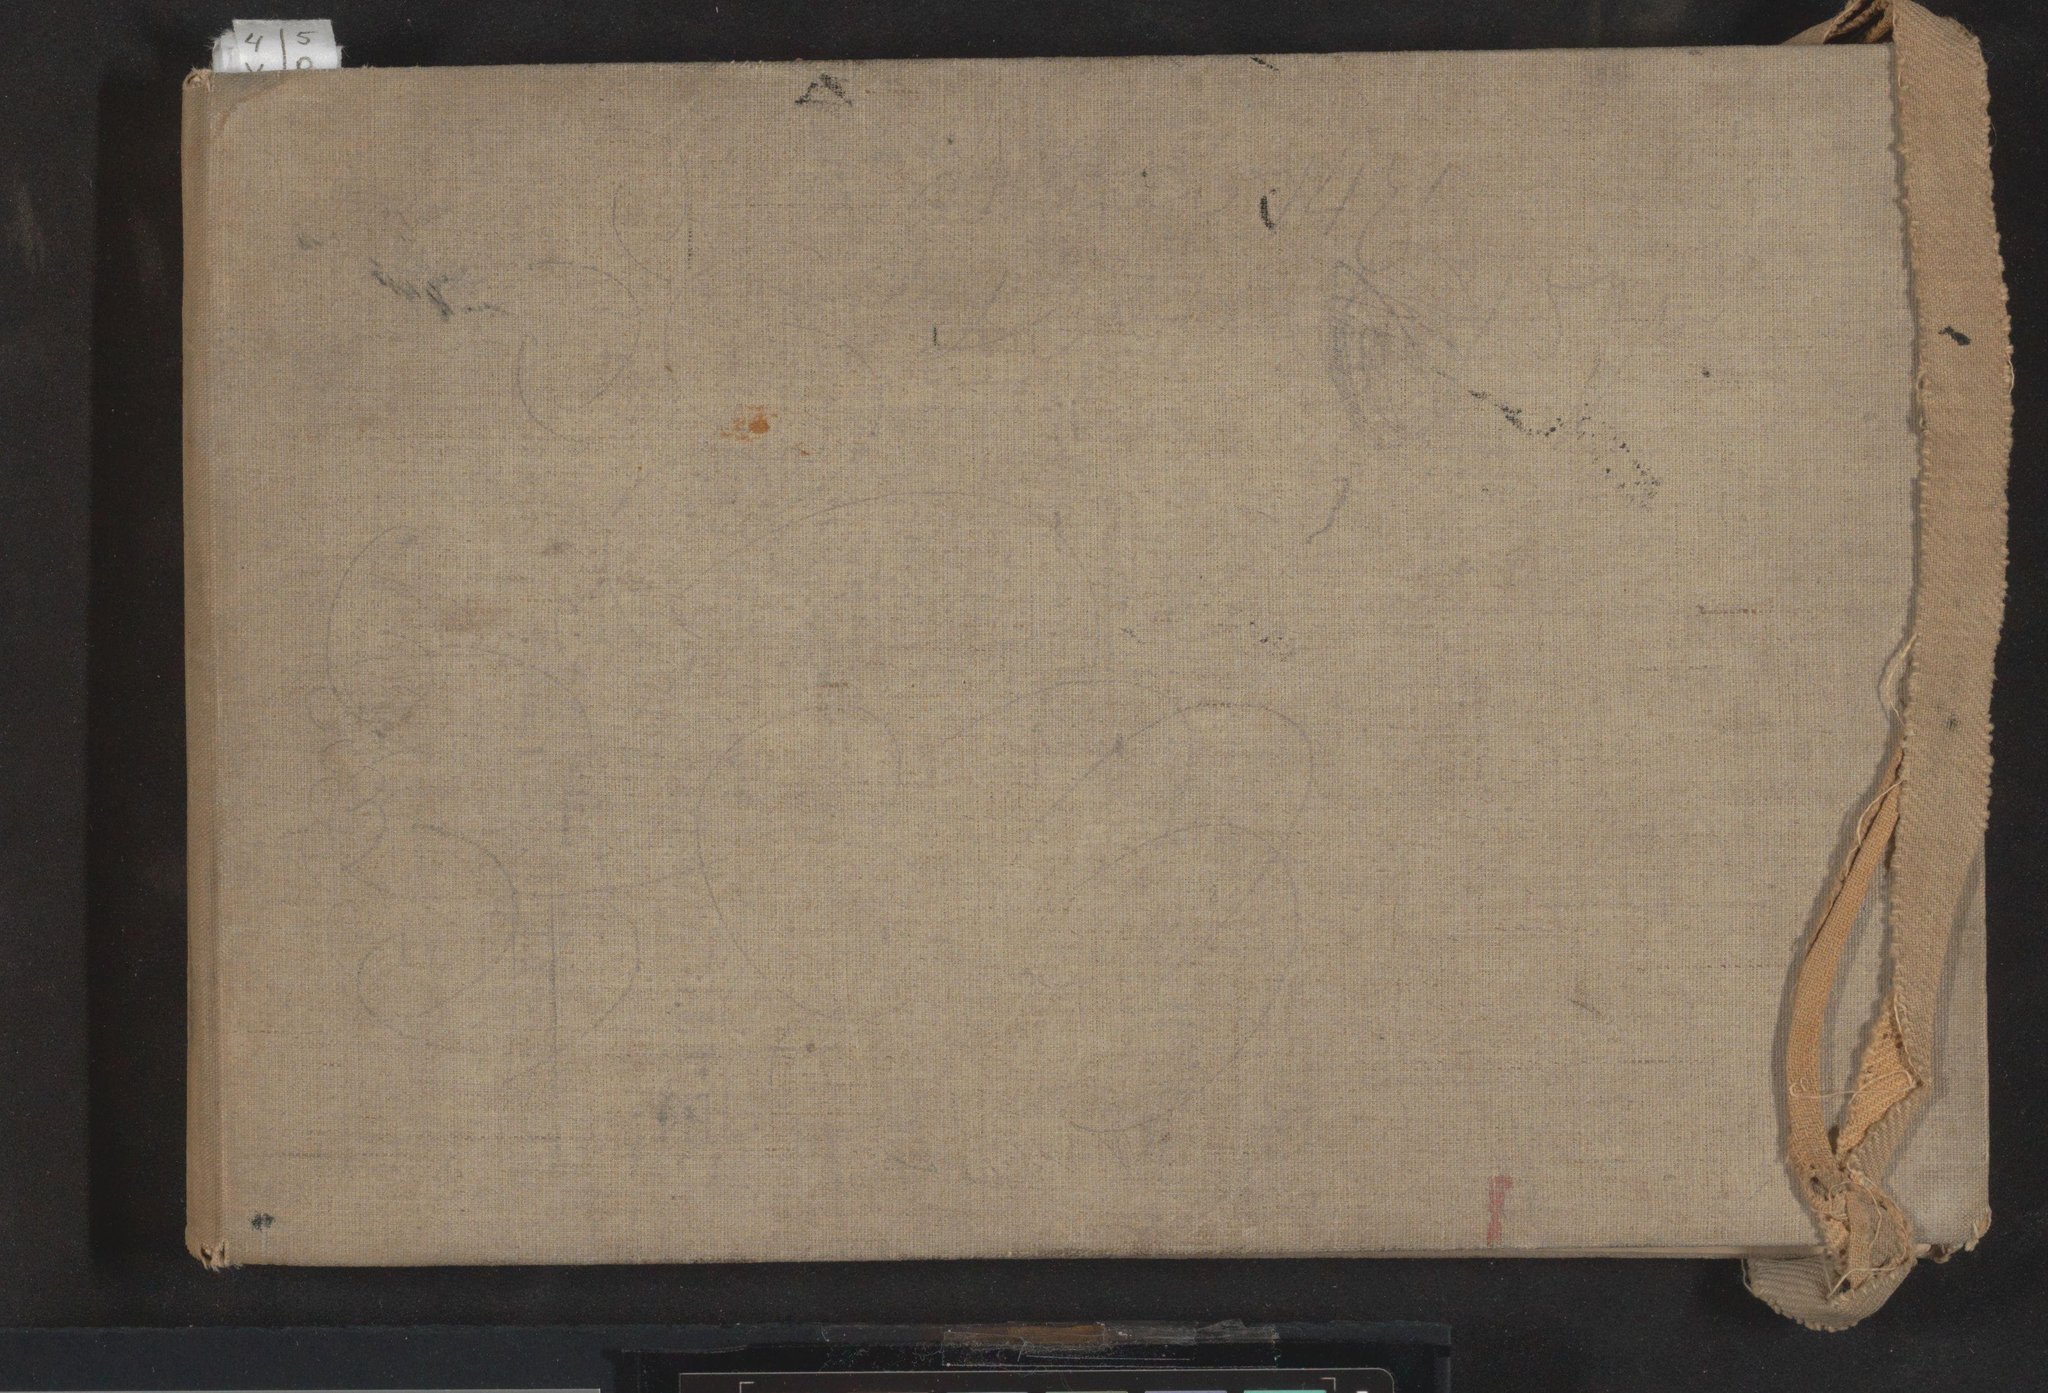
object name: sketchbook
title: Schetsboek met 49 bladen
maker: johanna van de kamer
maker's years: 1873-1922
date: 1890-1922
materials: cardboard, paint, ink, linen, paper, pencil, watercolor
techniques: brush, pen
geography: netherlands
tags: ornaments ~ art, calligraphy, exterior ~ representation of a building, antwerp, royal palace of amsterdam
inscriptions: signature: ‘JHvandeKamer’, collector's mark: Lugt 2228a, retailer's mark: ‘C.L.C.VOSKUIL/ Reguliersbreestraat/ 1.50’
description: Schetsboek bestaande uit 49 bladen met gebouwen in Nederland, Italië en Frankrijk, kunstnijverheid, kalligrafie, ornamenten en decoratieve patronen en motieven, onder andere uit het Verre Oosten. Vermoedelijk gemaakt naar voorbeeldboeken tijdens tekenlessen aan de academie te Amsterdam. Op de voorzijde van de band potloodschetsen.